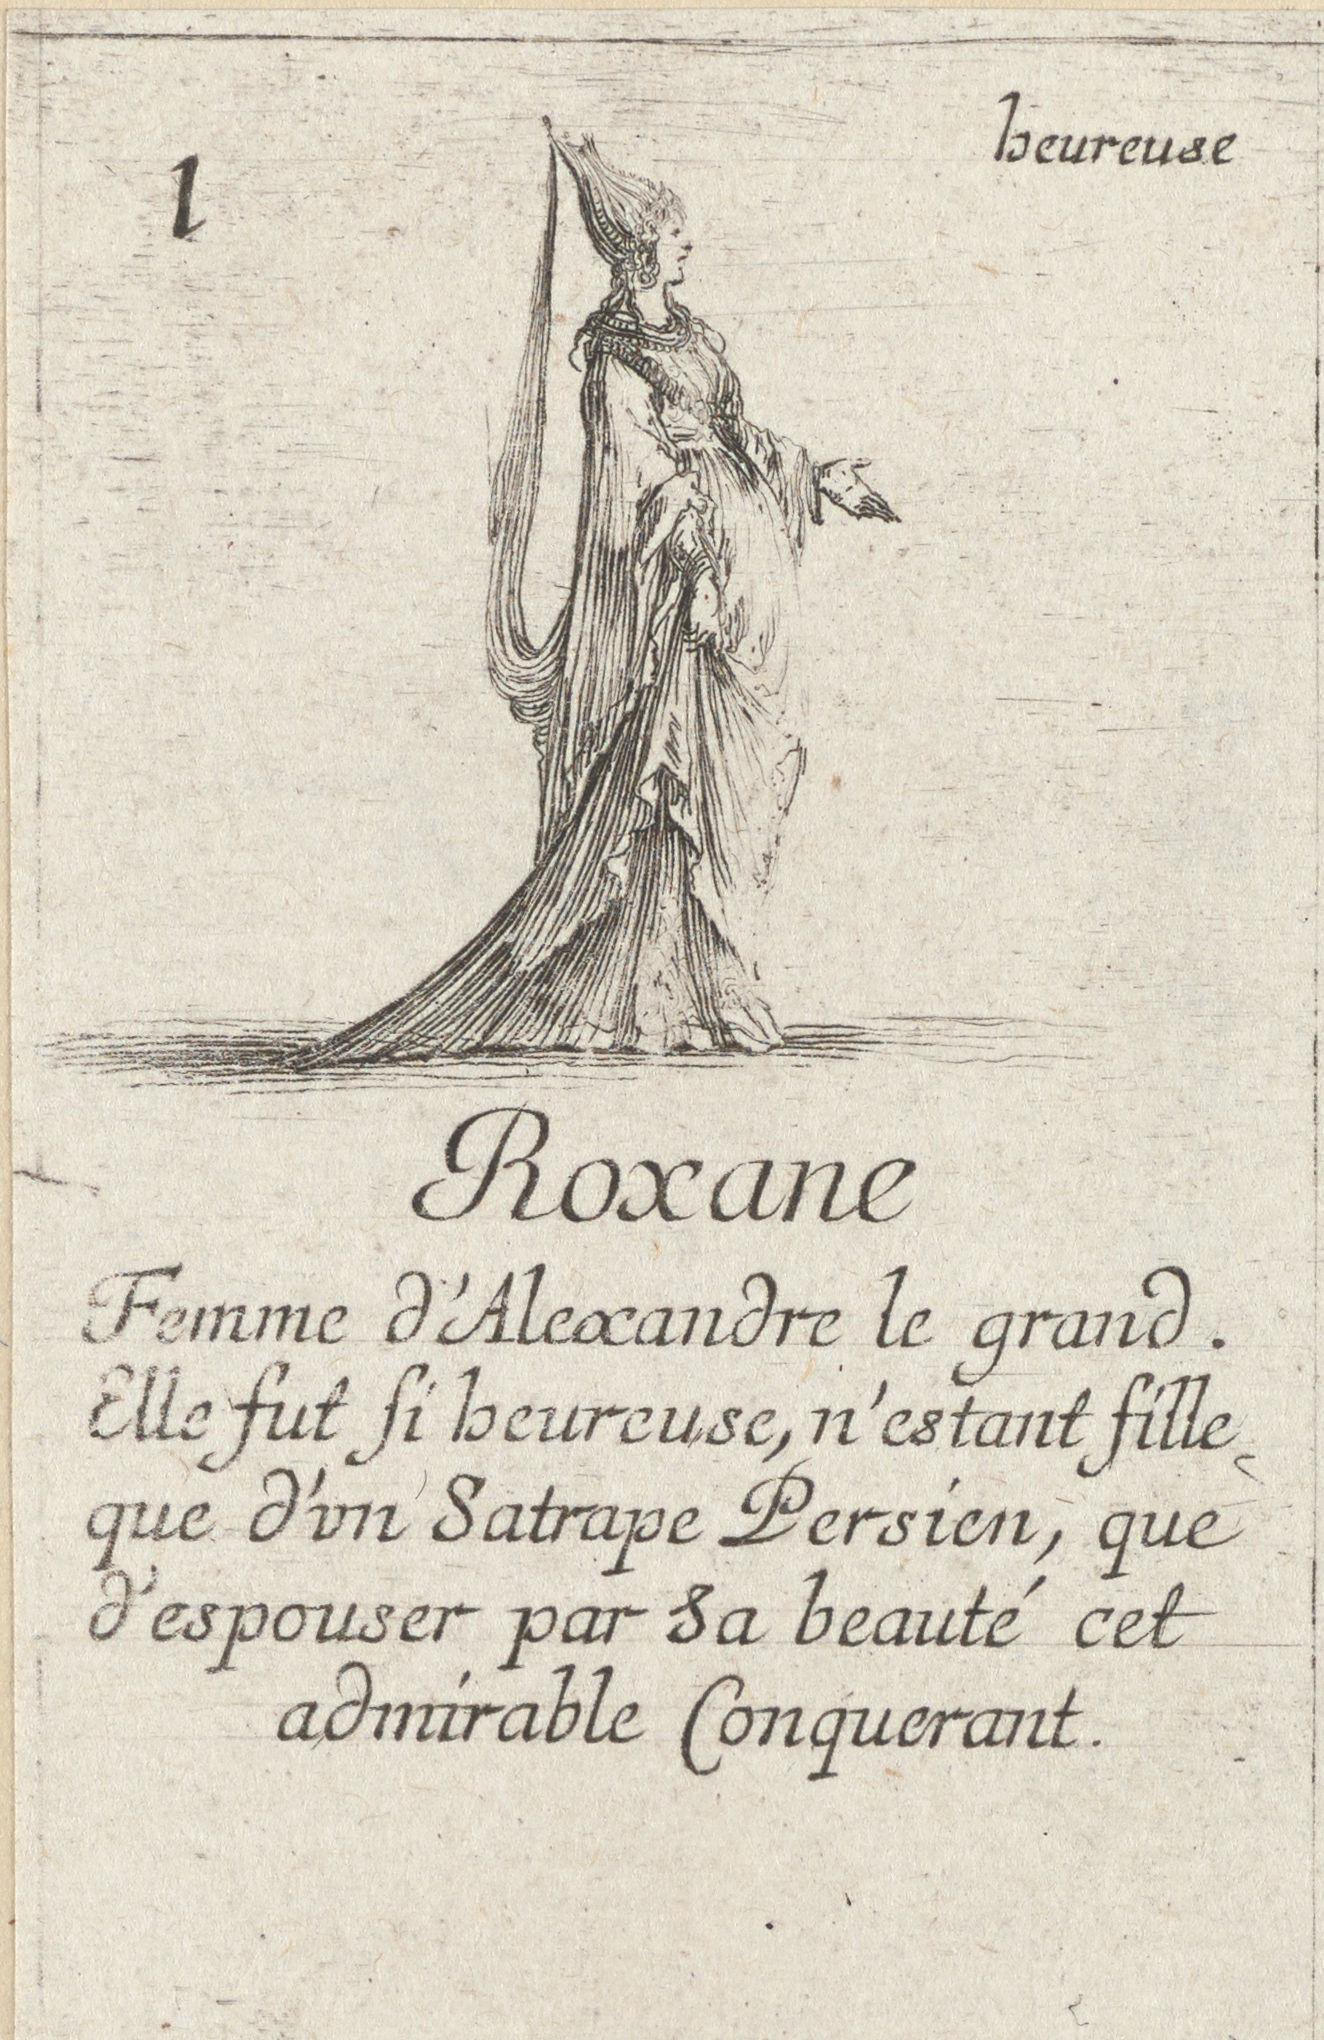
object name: playing card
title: Roxane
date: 1620-1664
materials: paper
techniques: etching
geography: paris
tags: ruler, sovereign - bb - female ruler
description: Deze prent maakt deel uit van een kaartspel met 52 kaarten met voorstellingen van beroemde koninginnen. De serie is uitgedacht door Jean Desmarests de Saint-Sorlin in opdracht van Kardinaal Mazarin. Het kaartspel werd gemaakt voor de jonge Lodewijk XIV, samen met het Jeu des Fables, Jeu de la Géographie en Jeu des Rois de France.